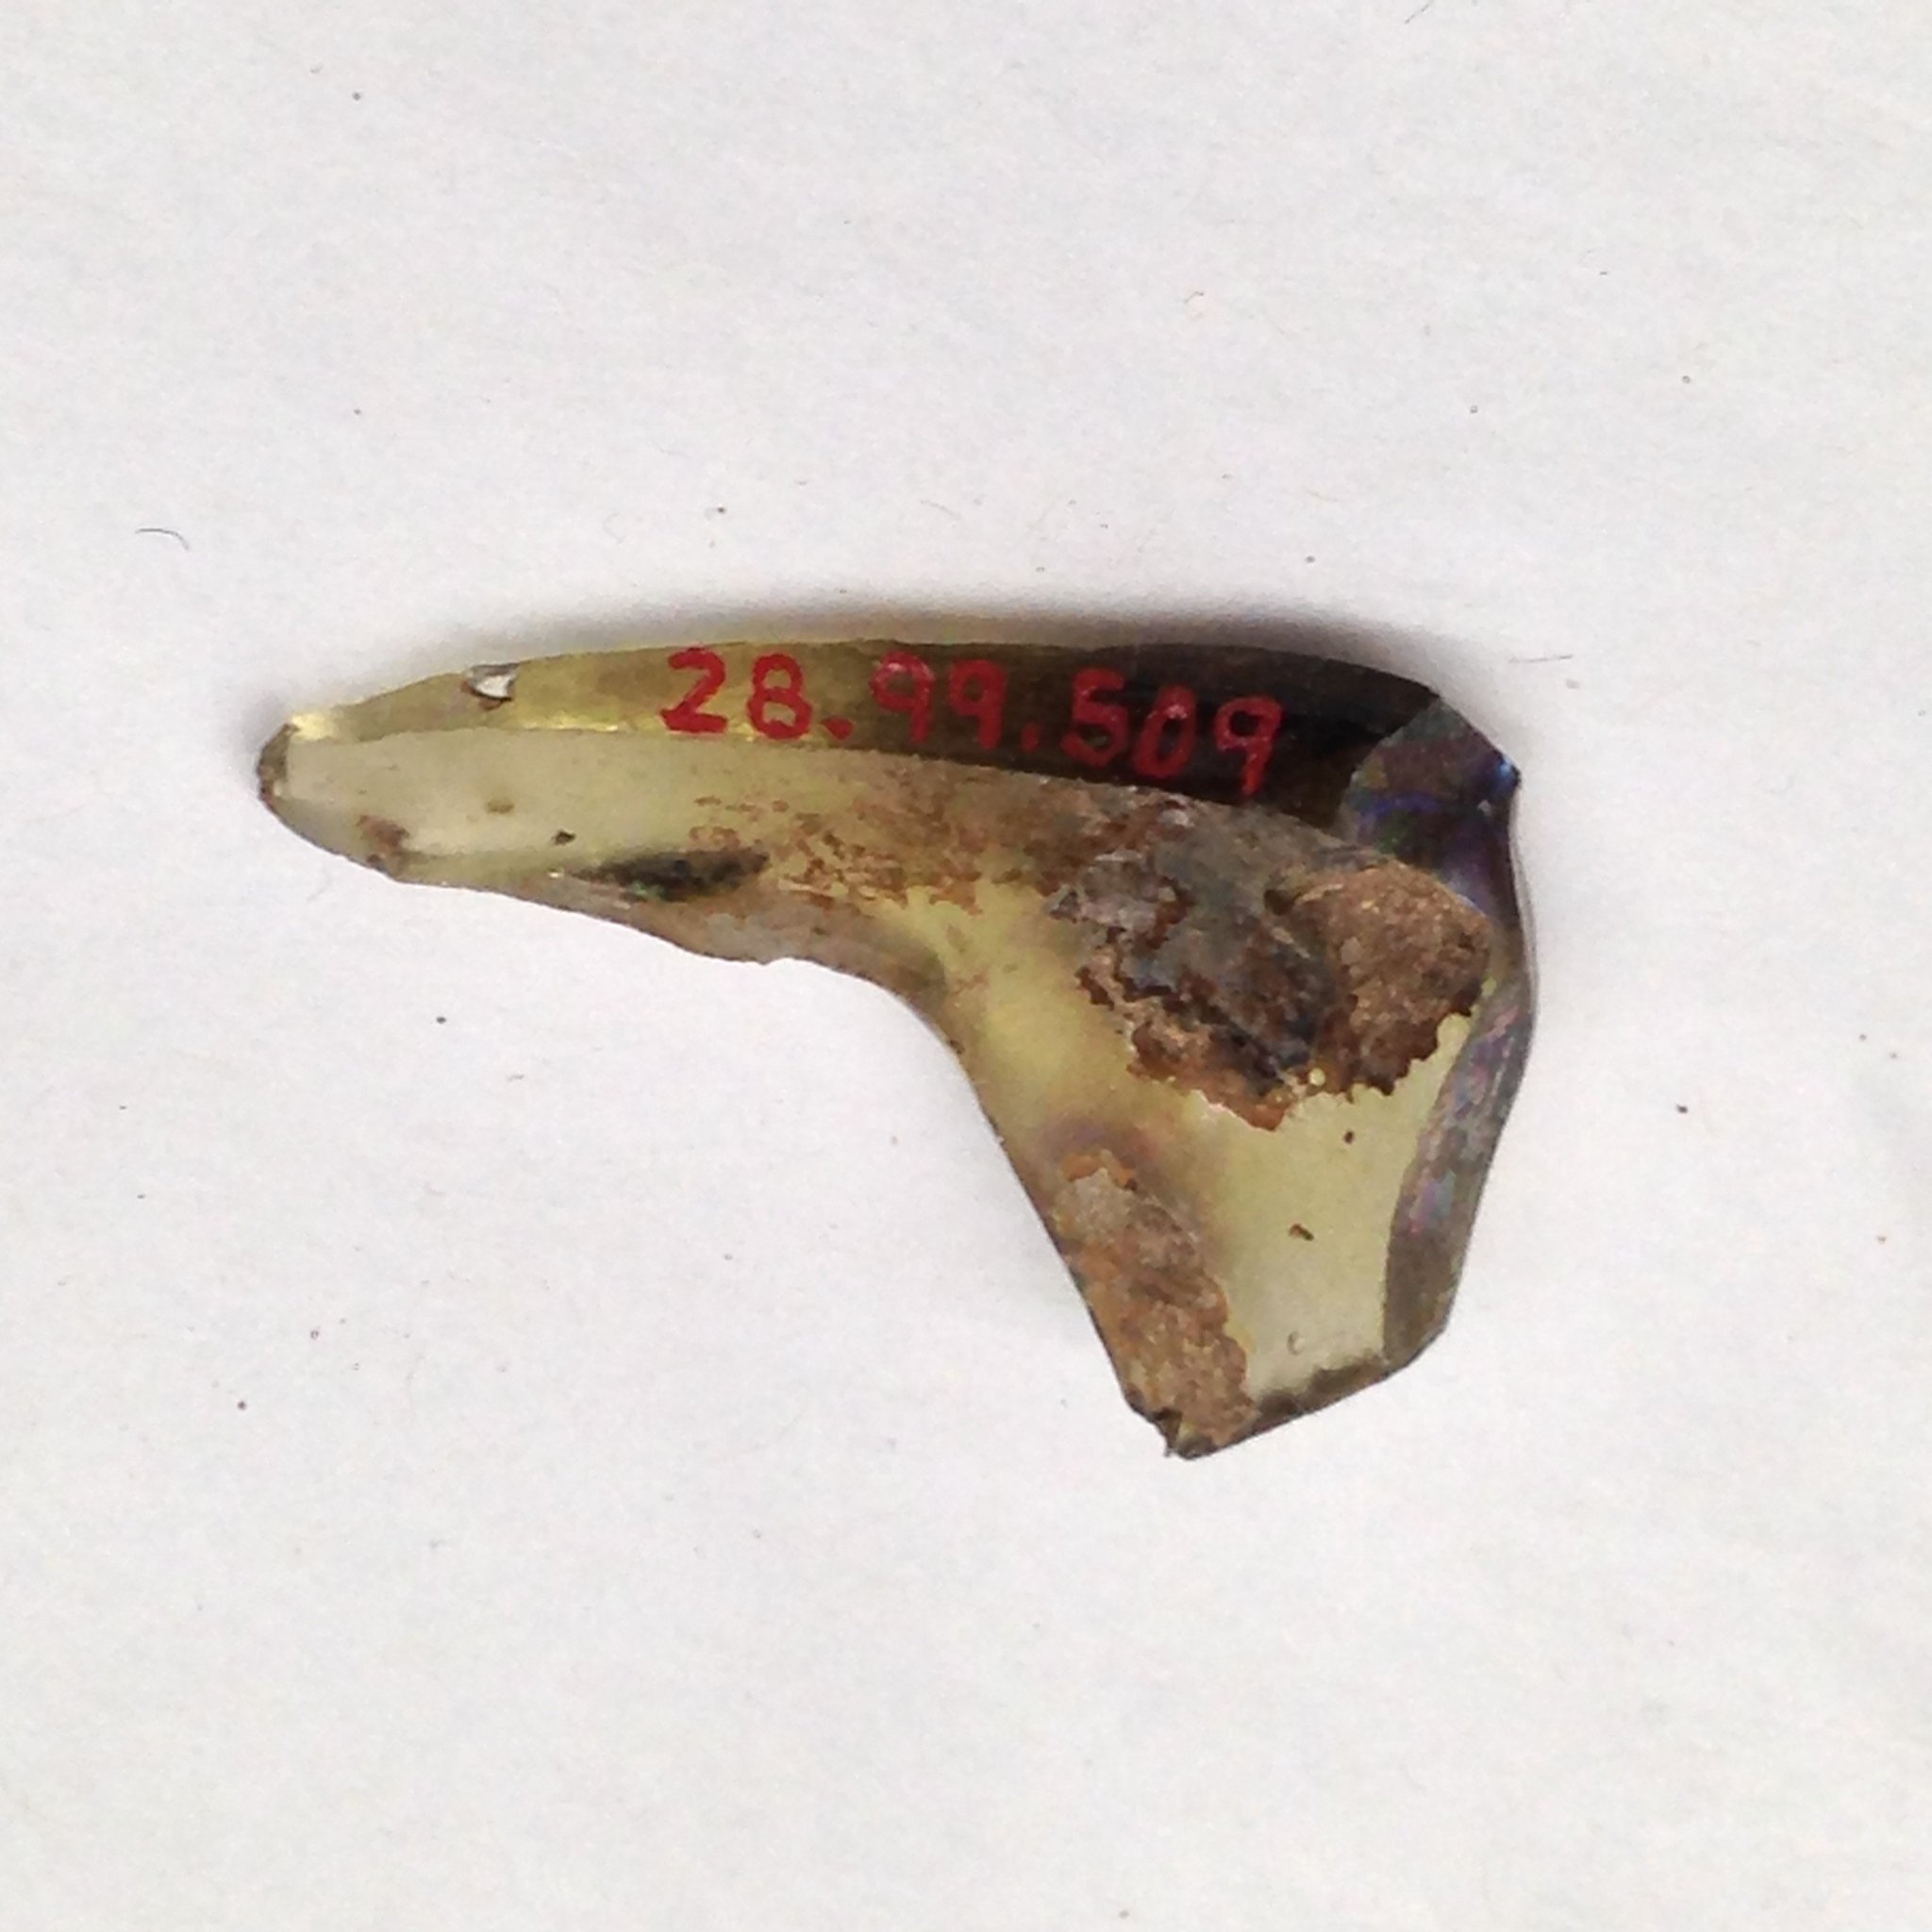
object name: fragment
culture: european or middle eastern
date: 1150-1250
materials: ceramic, glass